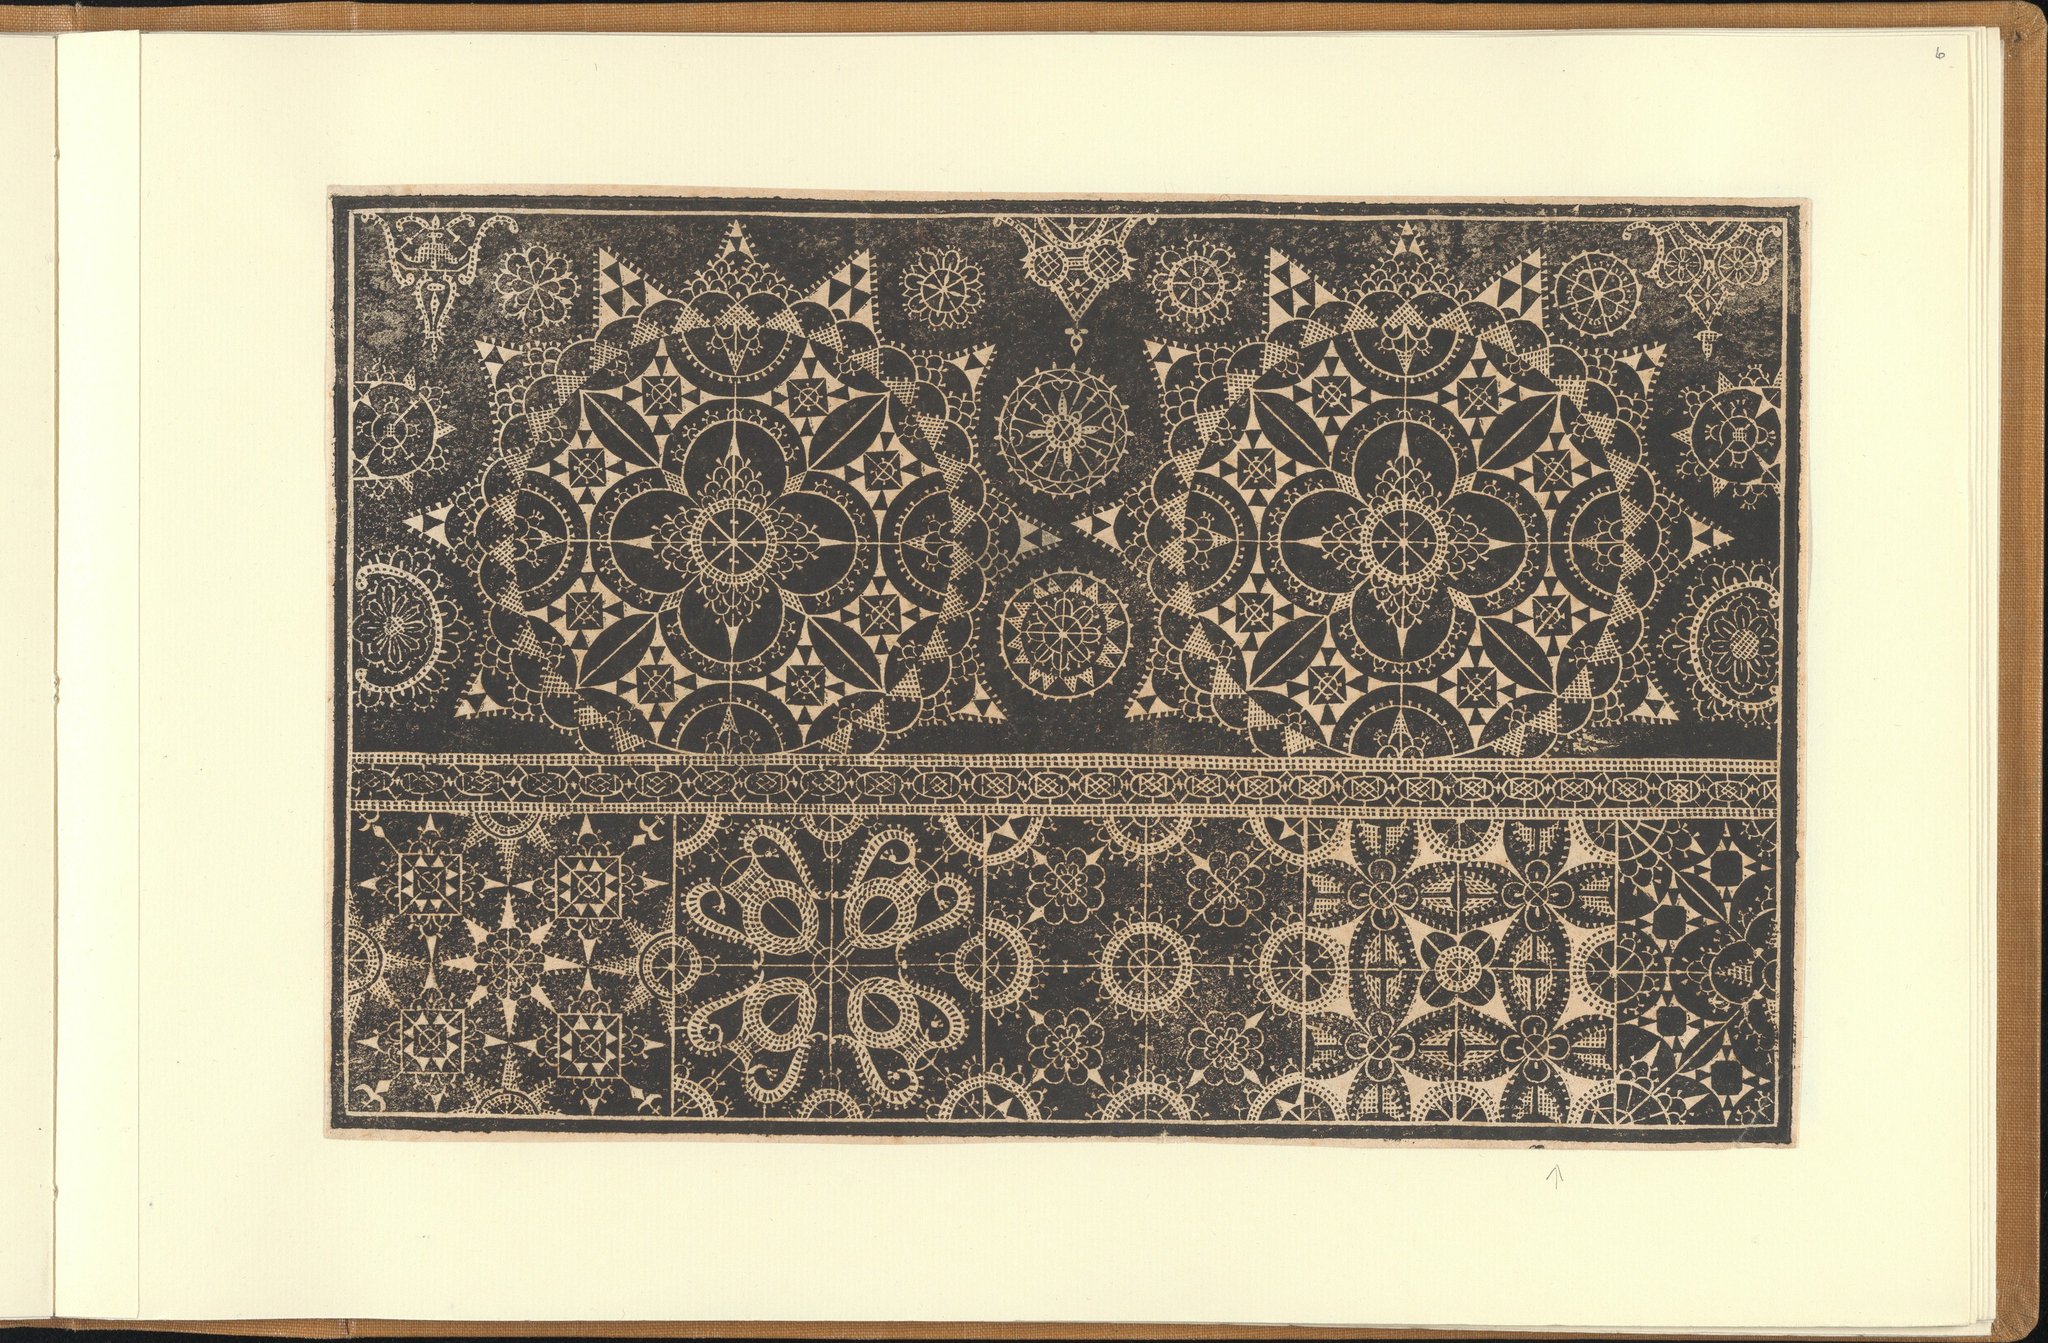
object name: album print ornament architecture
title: Schon newes Modelbuch...Page 6(r)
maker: sigismundus latomus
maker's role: designer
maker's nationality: german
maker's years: 1599-1632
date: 1617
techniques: woodcut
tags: ornament